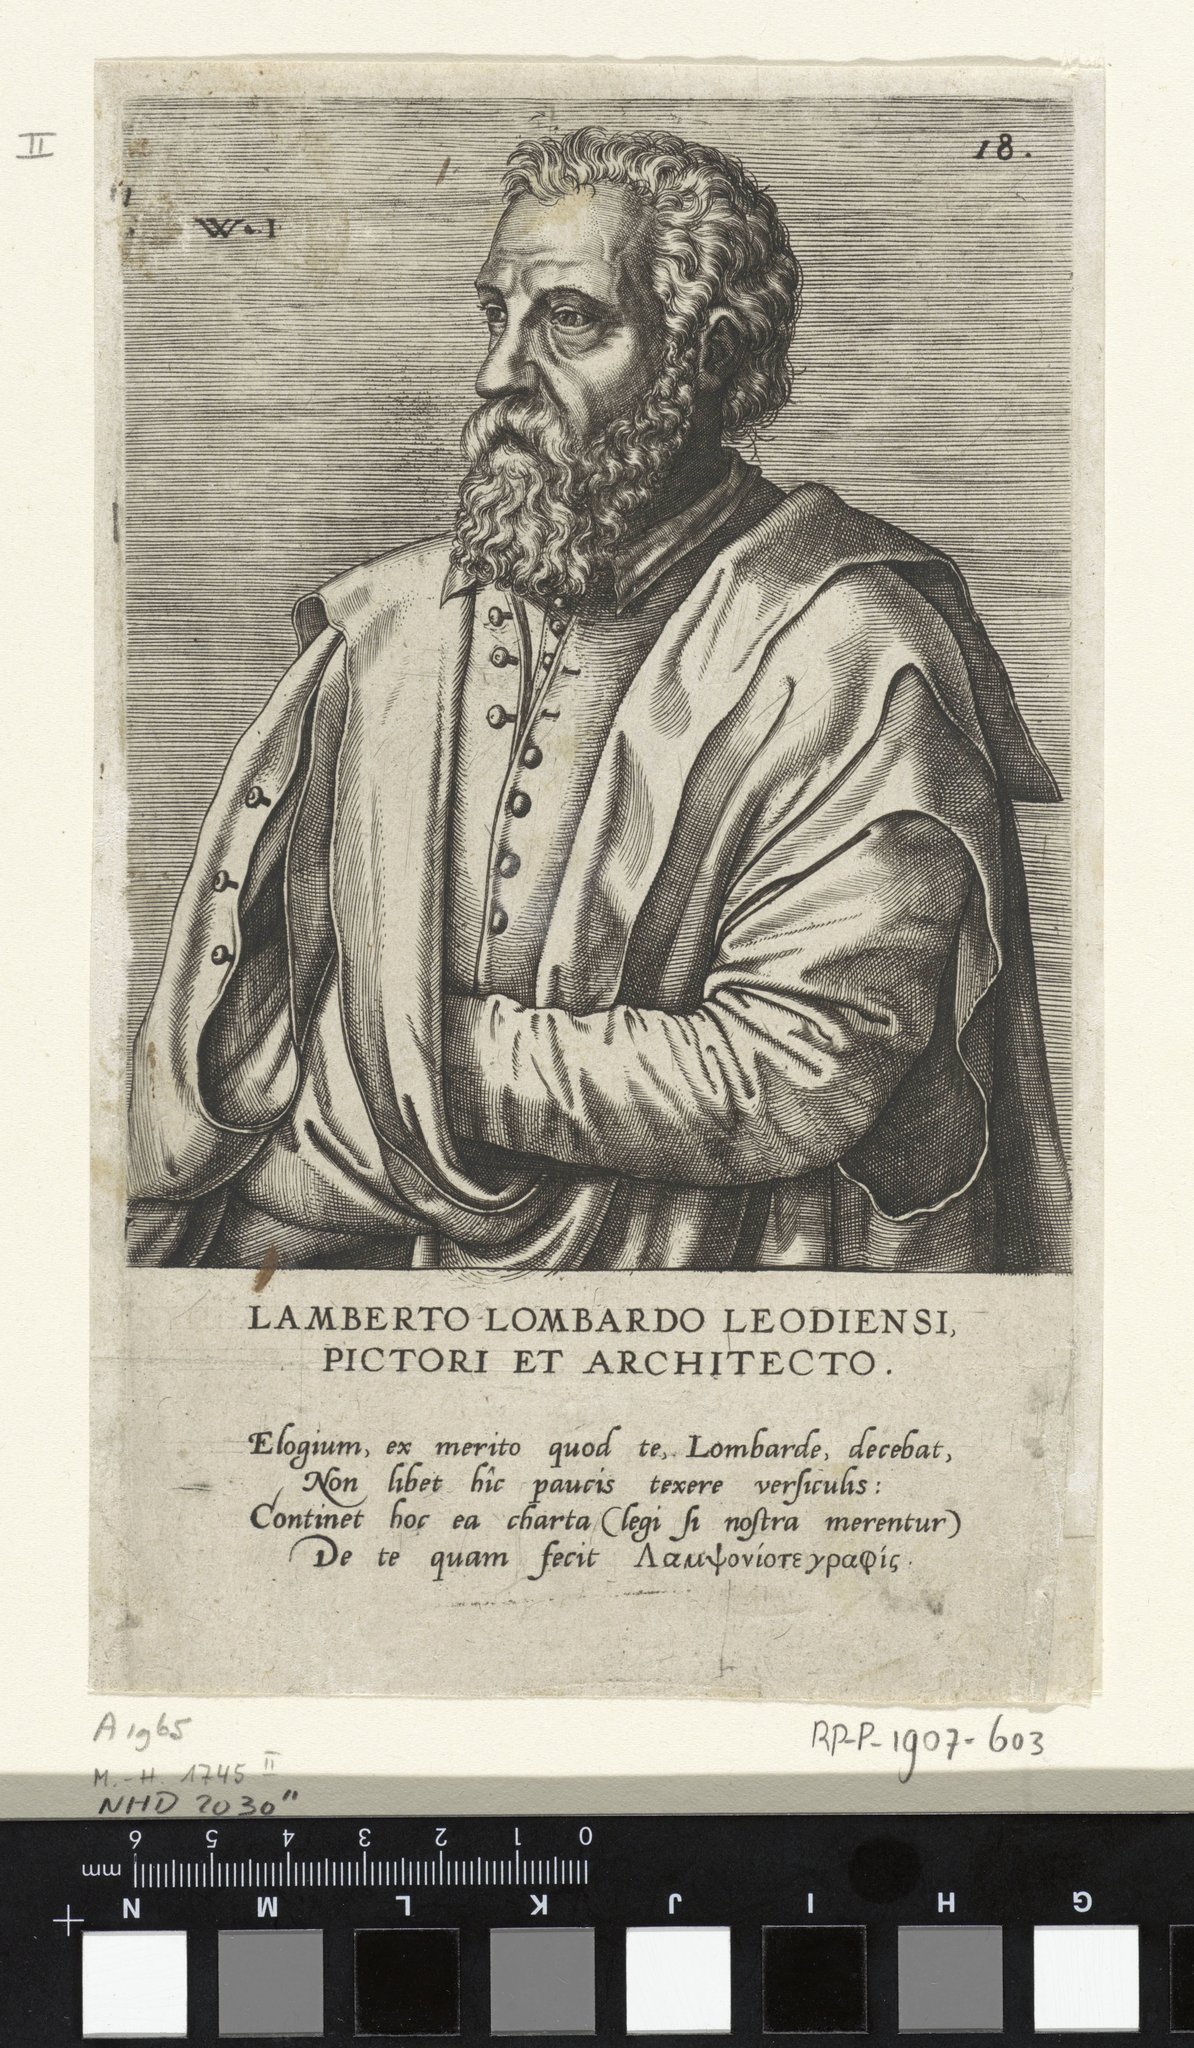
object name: print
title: Portretten van schilders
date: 1572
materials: paper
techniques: engraving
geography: antwerp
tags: print maker, draughtsman, lambert lombard, portrait, self-portrait of painter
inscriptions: collector's mark: Lugt 2228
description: In de marge een vierregelig onderschrift in het Latijn en aan het eind Griekse woorden.